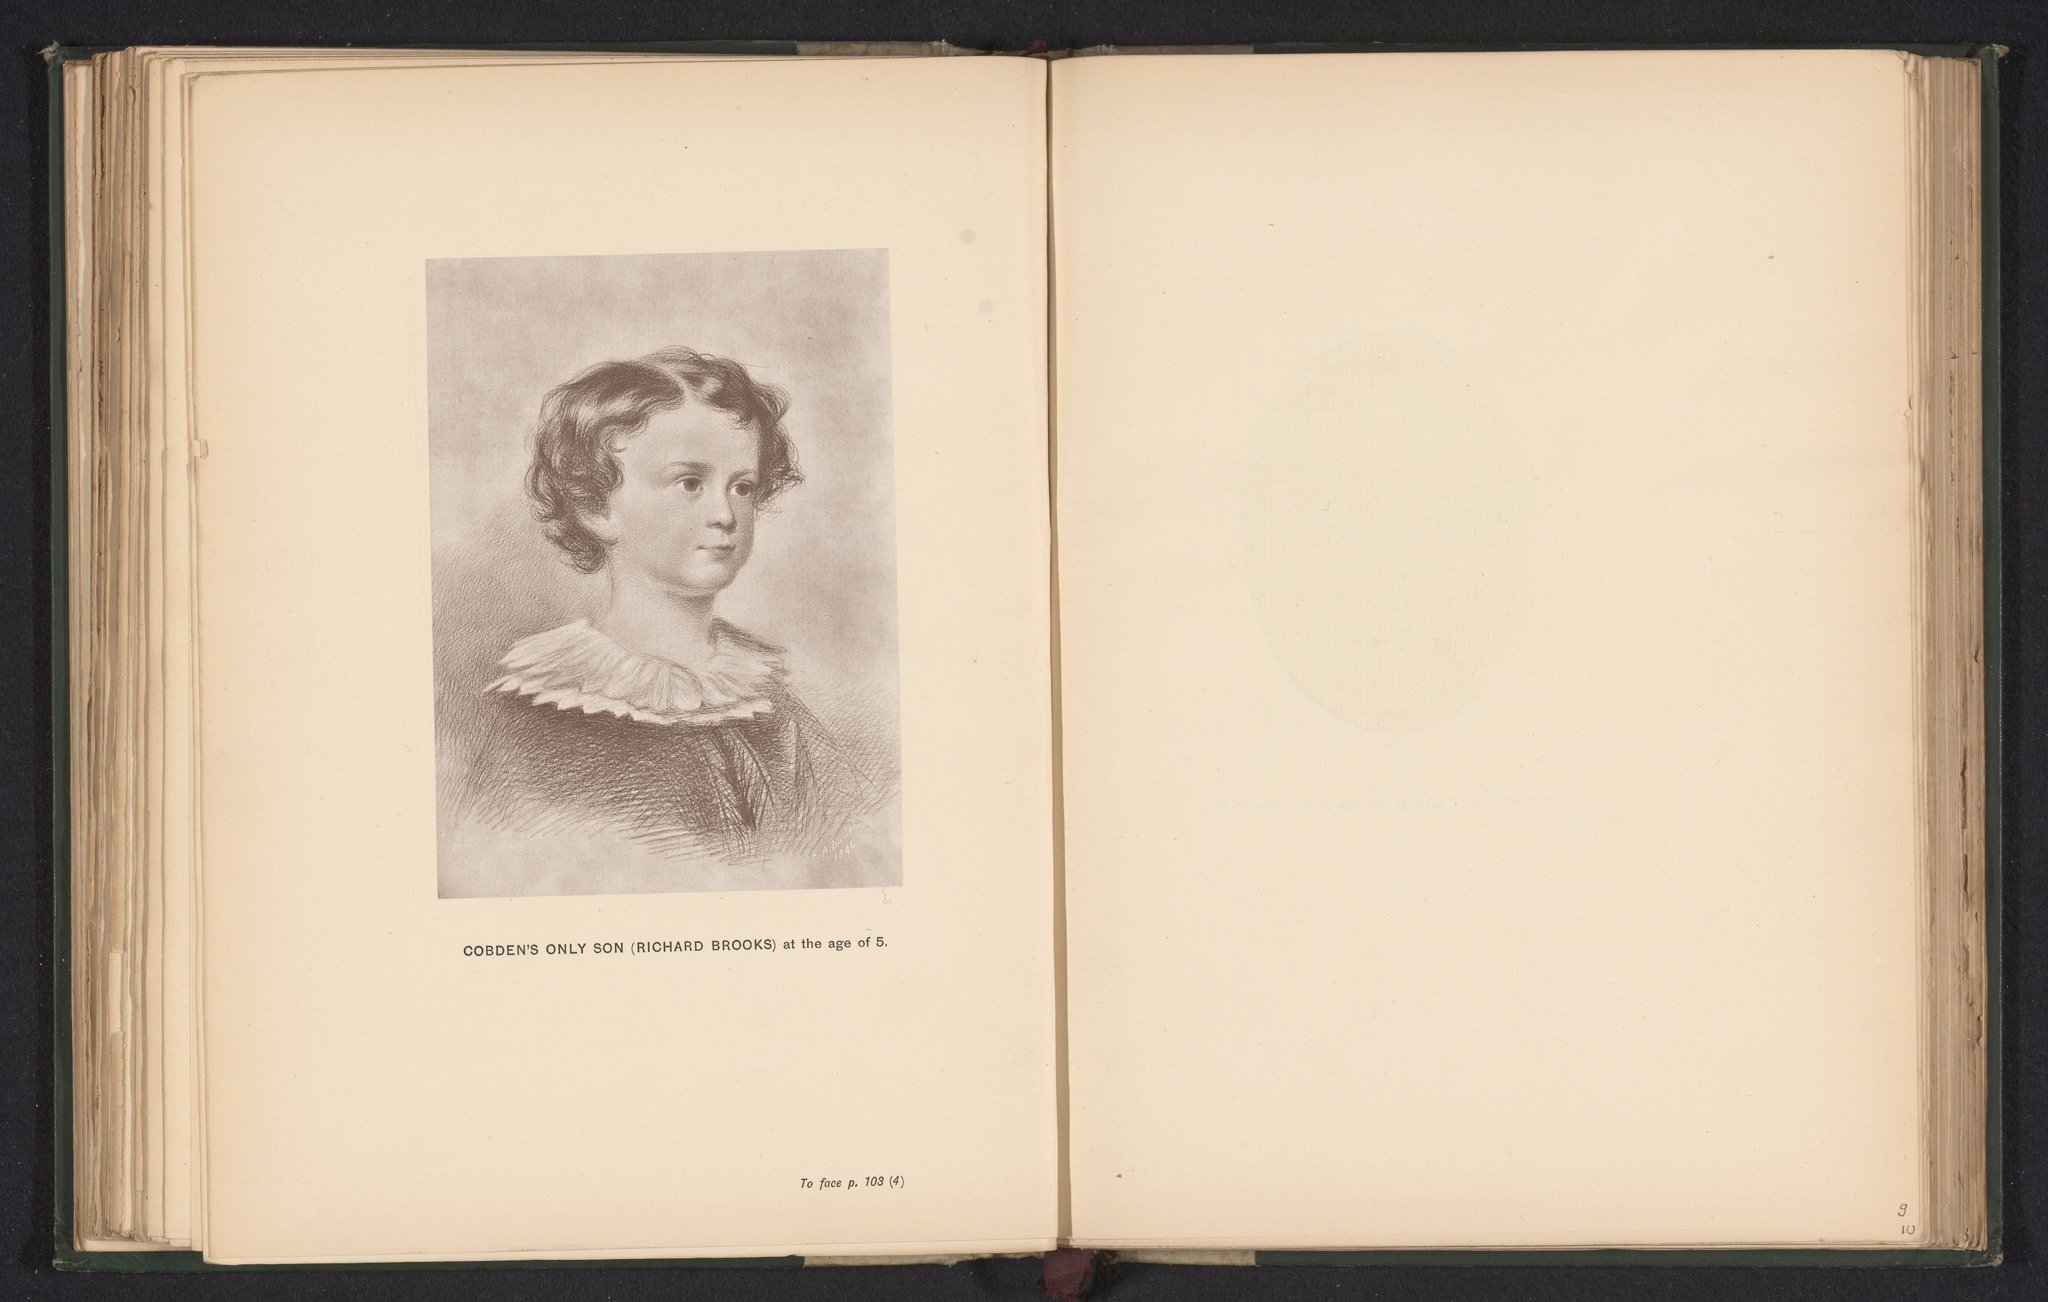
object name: photomechanical print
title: Fotoreproductie van een tekening van Richard Brooks, de zoon van Richard Cobden door Charles Allen Duval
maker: Anonymous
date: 1881-1891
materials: paper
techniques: woodburytype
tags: boy (child between toddler and youth)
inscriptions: name: ‘C.A. Duval 1846’